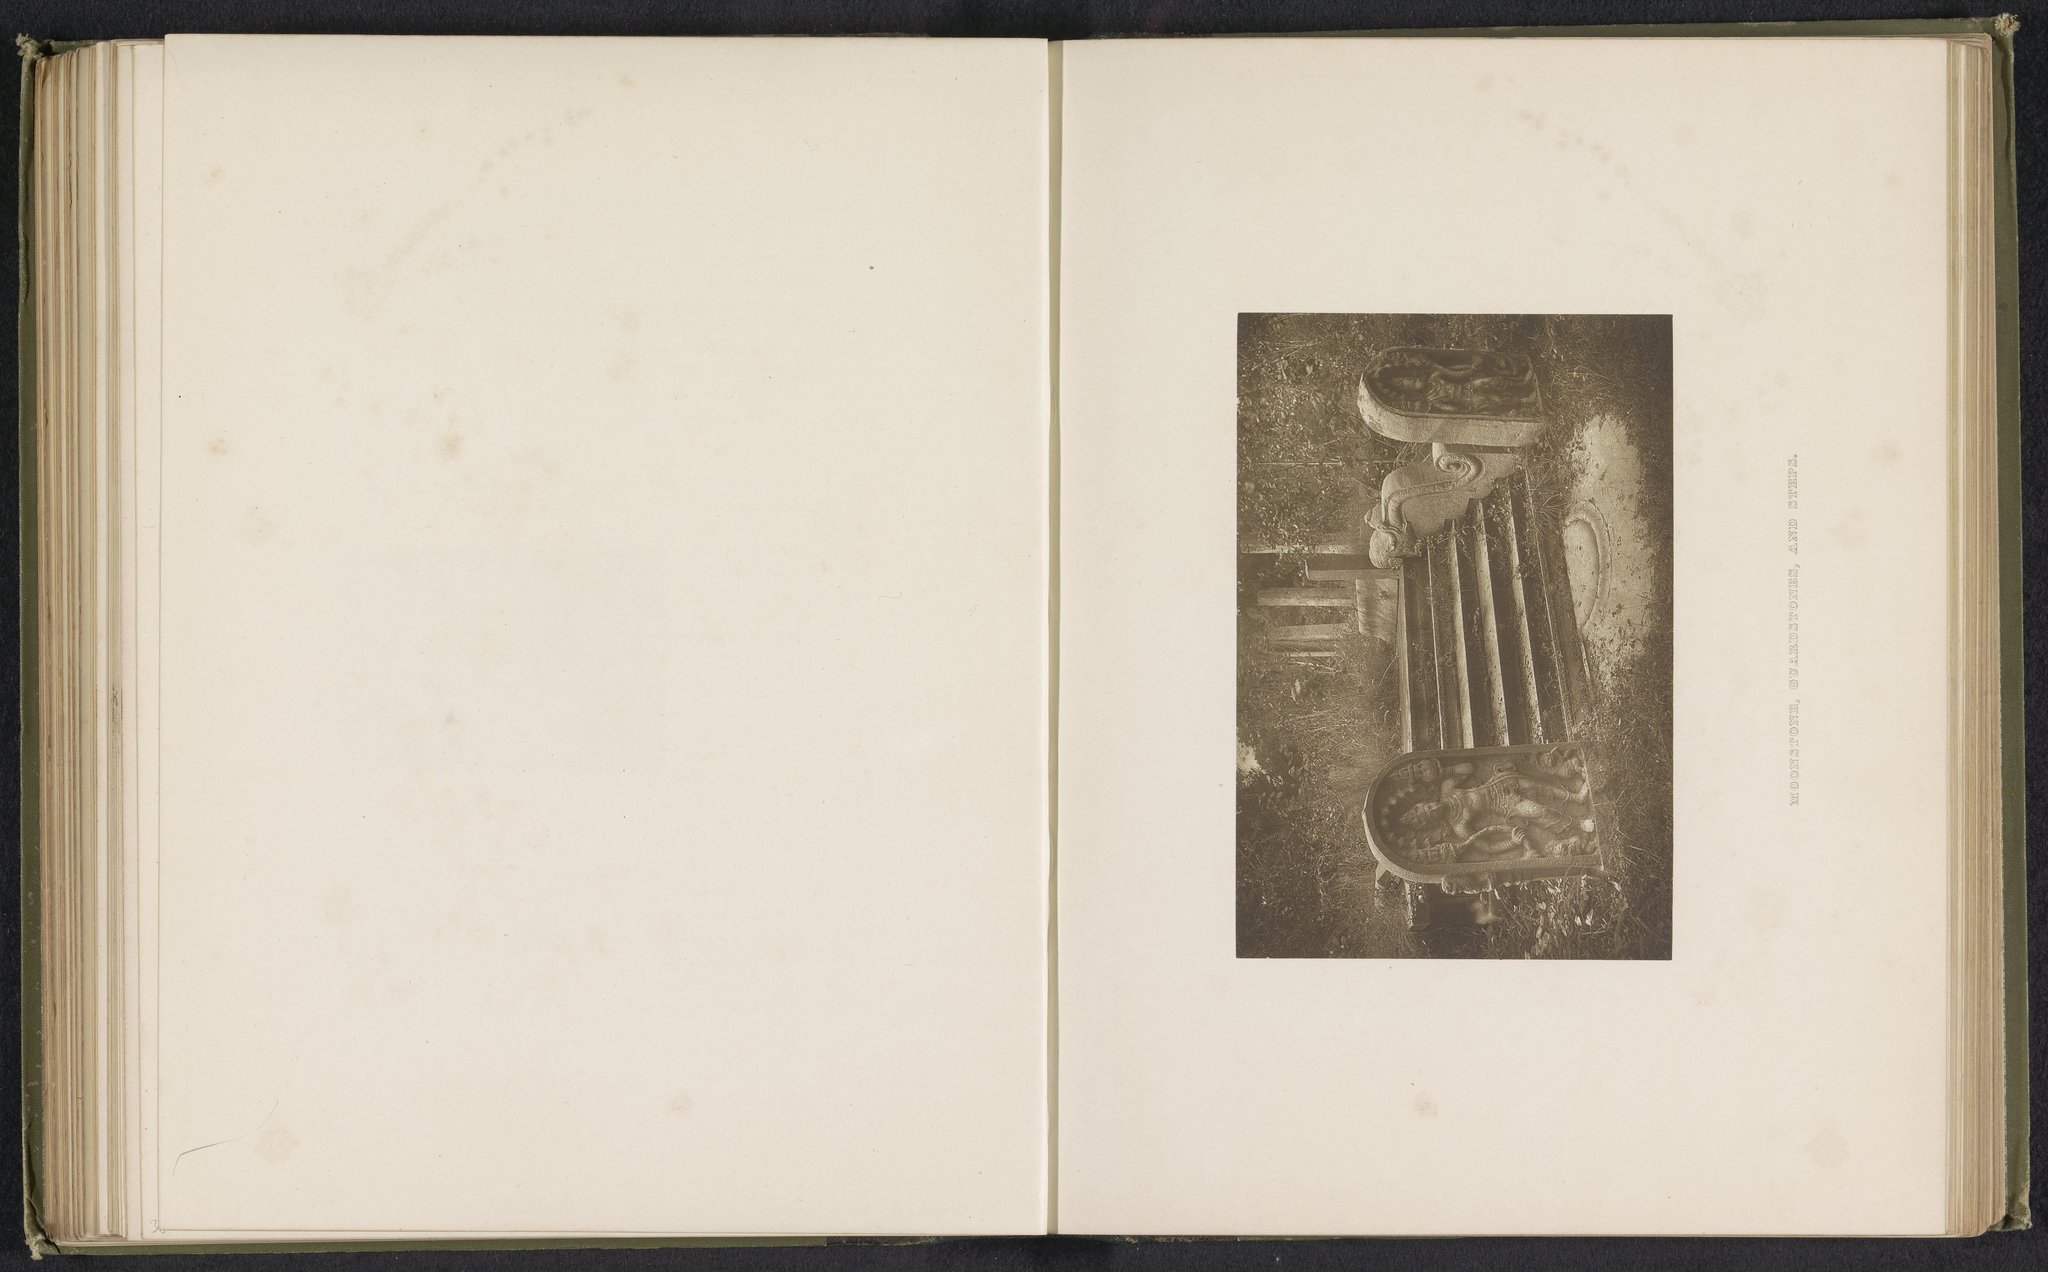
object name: page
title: Stone staircase with a moonstone and reliefs representing guardians, Anuradhapura, Sri Lanka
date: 1896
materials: paper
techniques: woodburygravure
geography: anuradhapura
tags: flight of steps, doorkeeper, house-guard (inanimate), sculpture (+ relief ~ sculpture)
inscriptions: title: ‘MOONSTONE, GUARDSTONES, AND STEPS.’